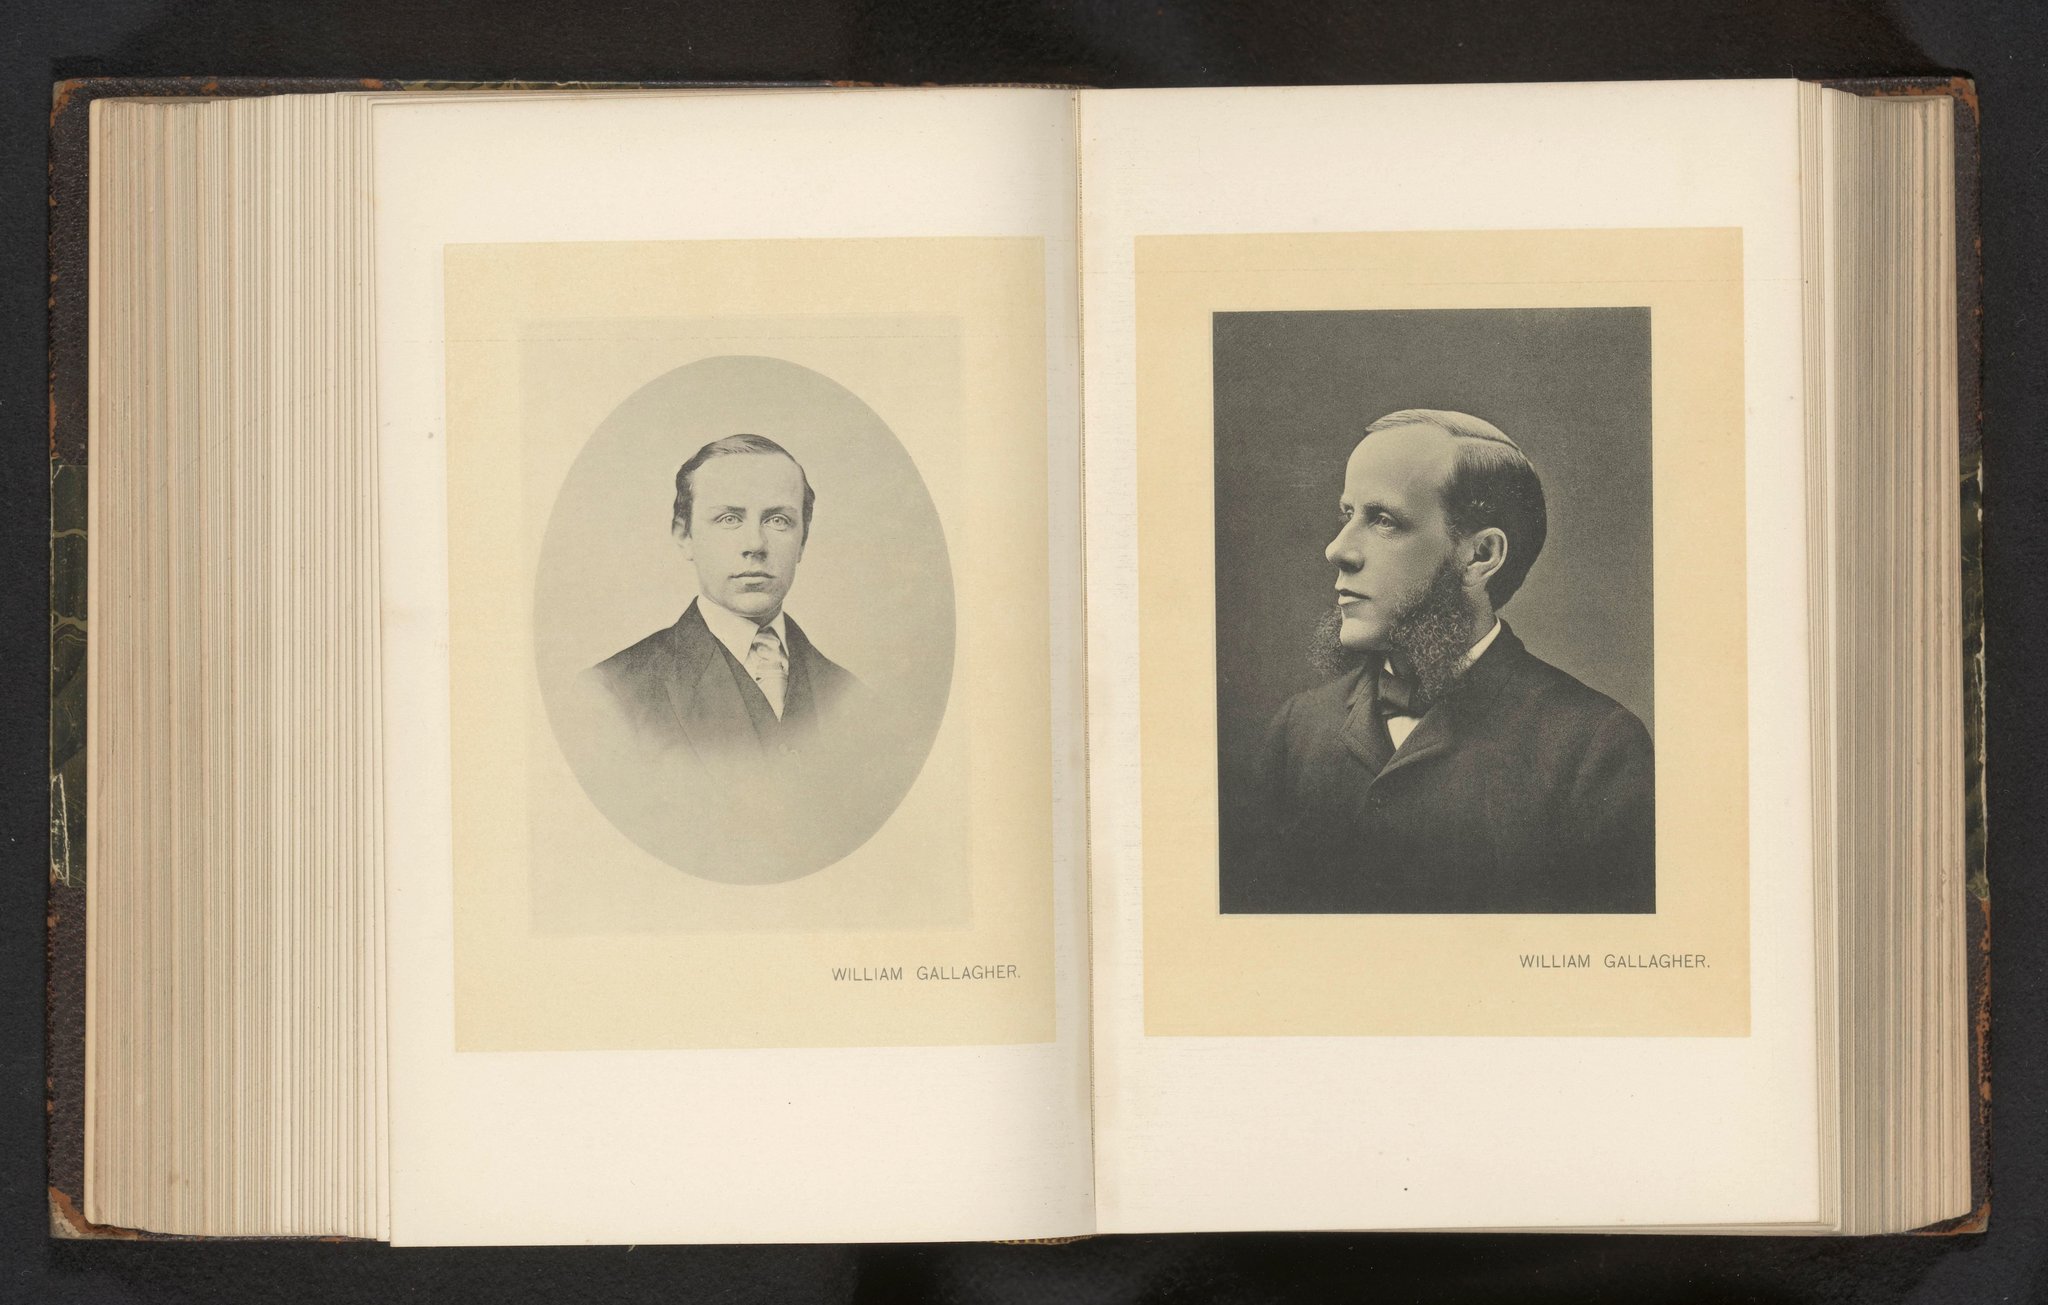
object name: photomechanical print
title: William Gallagher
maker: Anonymous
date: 1889-1894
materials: paper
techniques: photoaquatint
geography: boston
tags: adult man